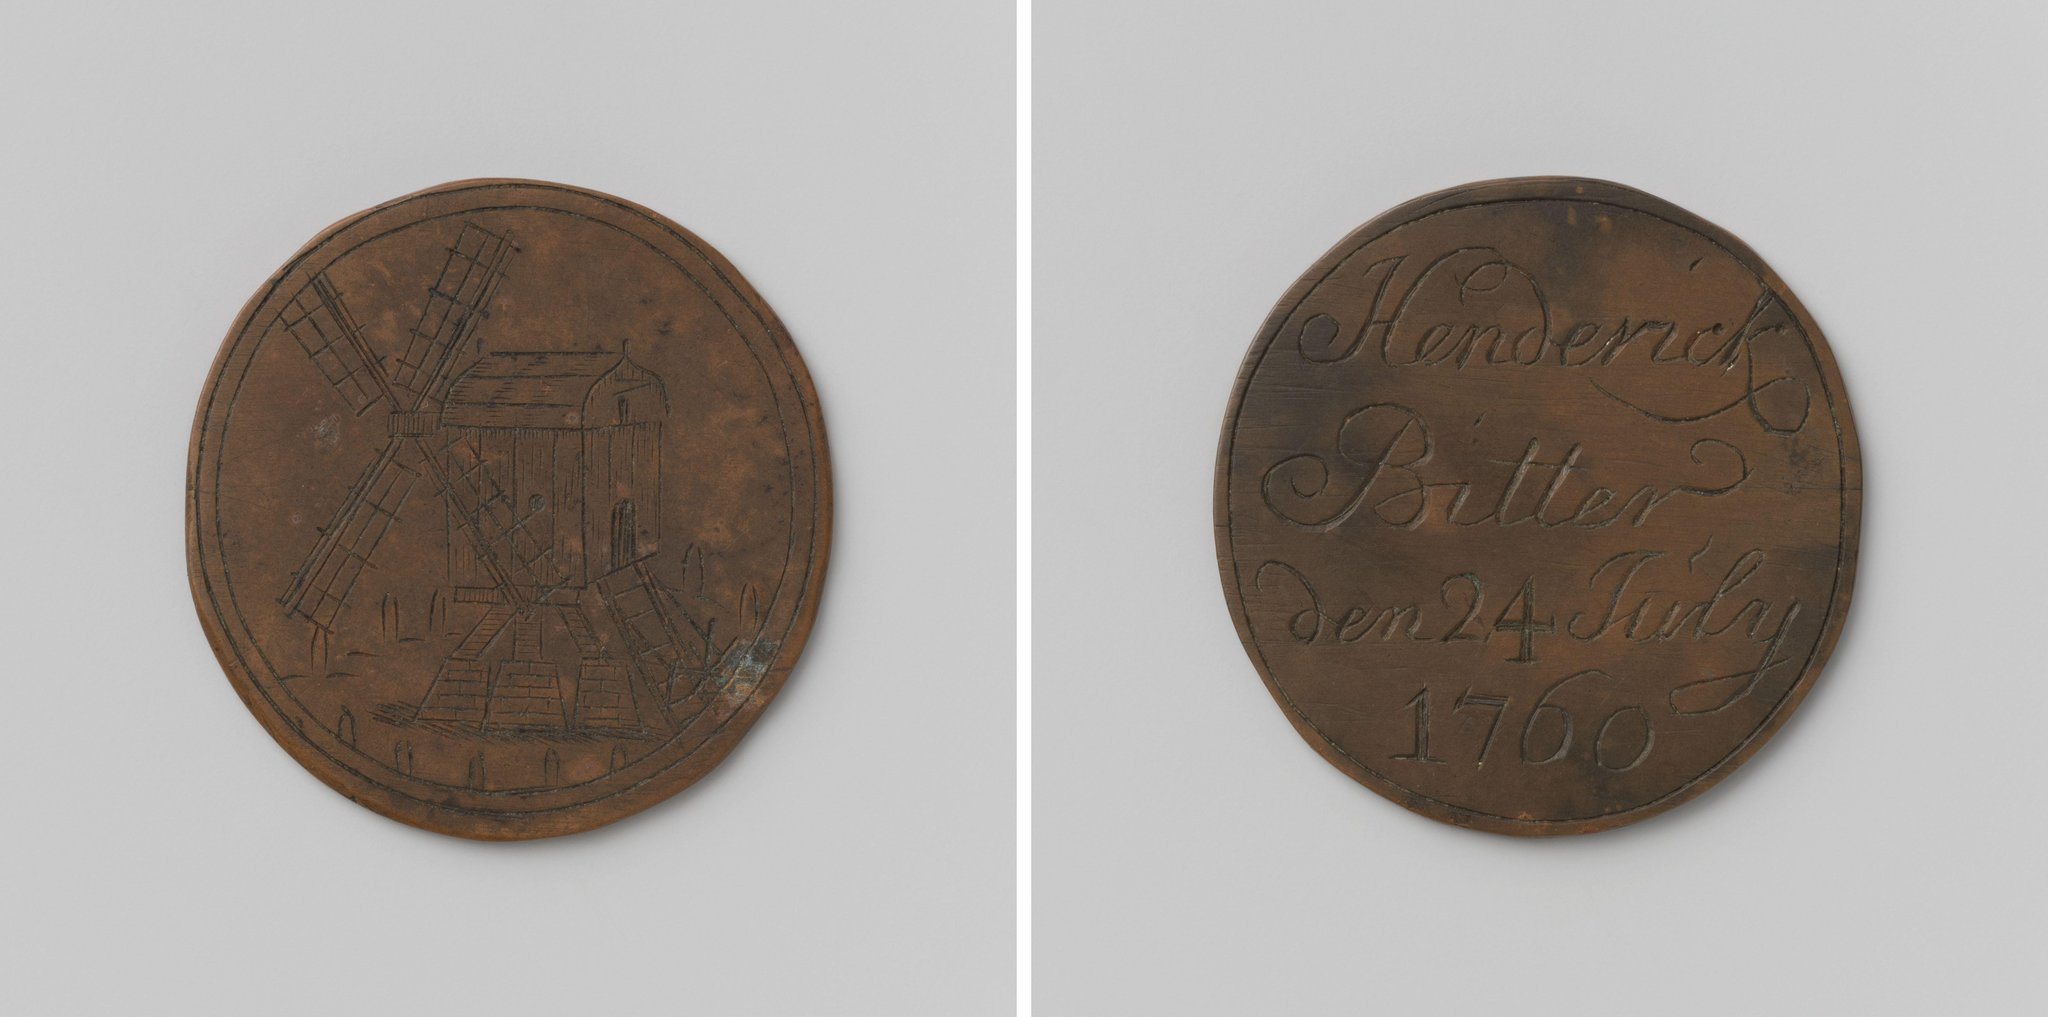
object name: medal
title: Korenmolenaarsgilde van Amsterdam, gildepenning van Henderick Bitter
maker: Anonymous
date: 1760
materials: copper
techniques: engraving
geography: amsterdam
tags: amsterdam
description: Koperen penning. Voorzijde: korenmolen. Keerzijde: opschrift